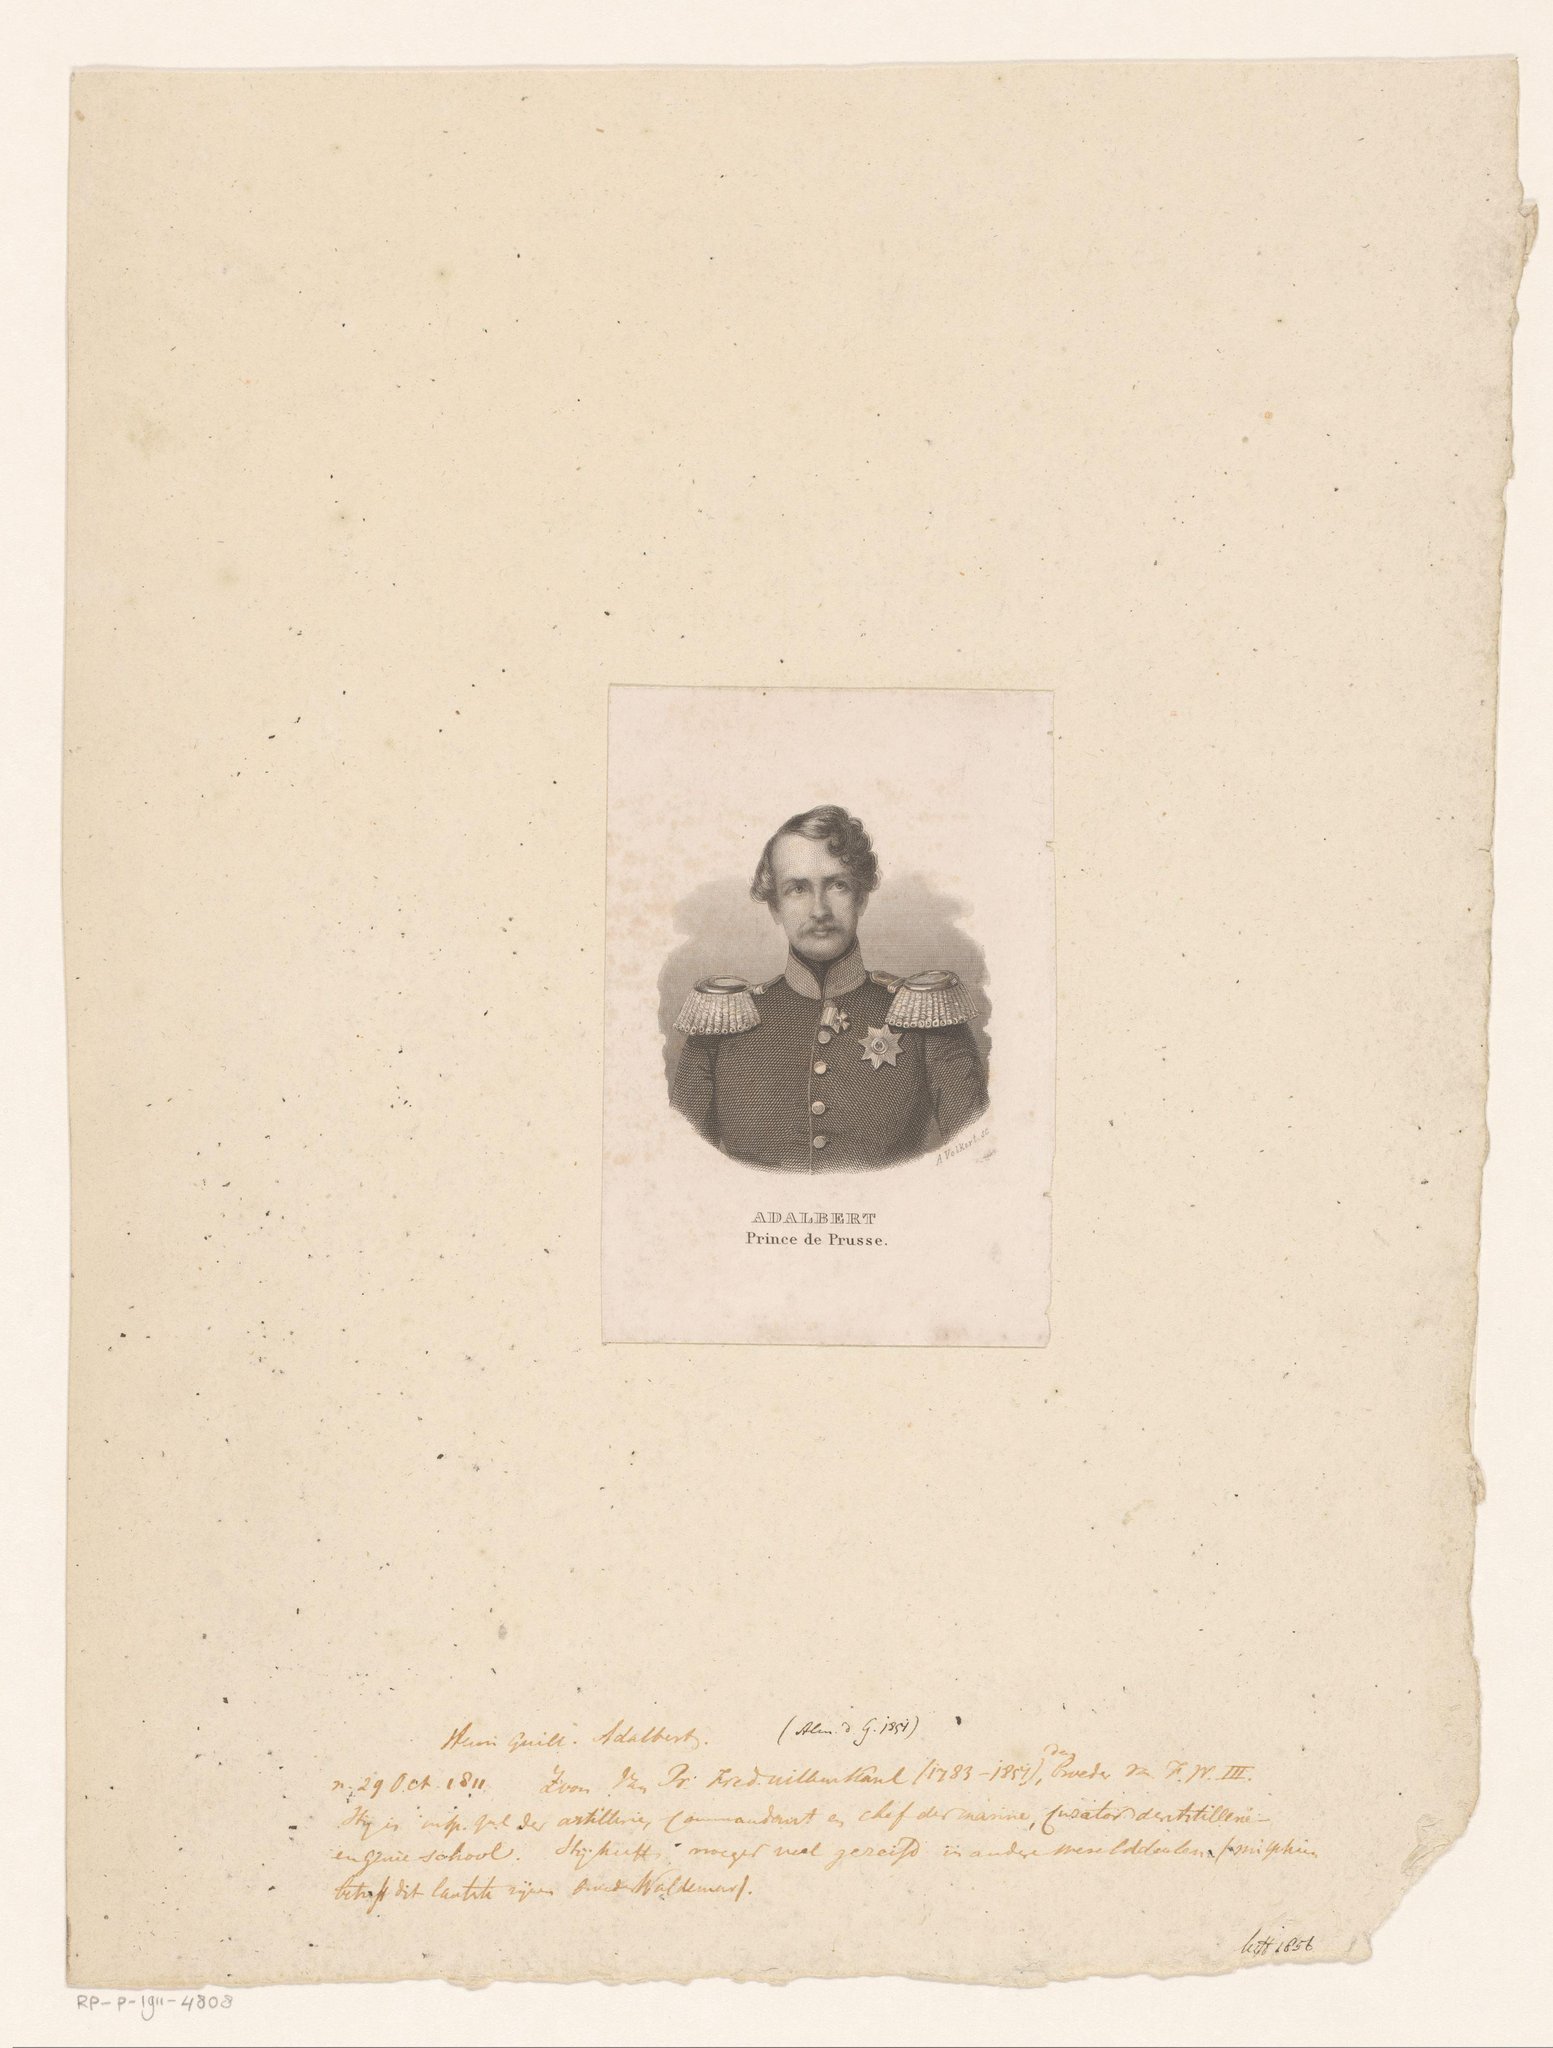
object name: print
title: Portret van Adalbert, prins van Pruisen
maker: august volkert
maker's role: print maker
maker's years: 1818-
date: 1830-1911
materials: paper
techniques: engraving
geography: germany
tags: berlin, historical persons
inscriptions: inscription: ‘A.d.G. 1851 / n. 29 oct. 1811.’, collector's mark: Lugt 2228